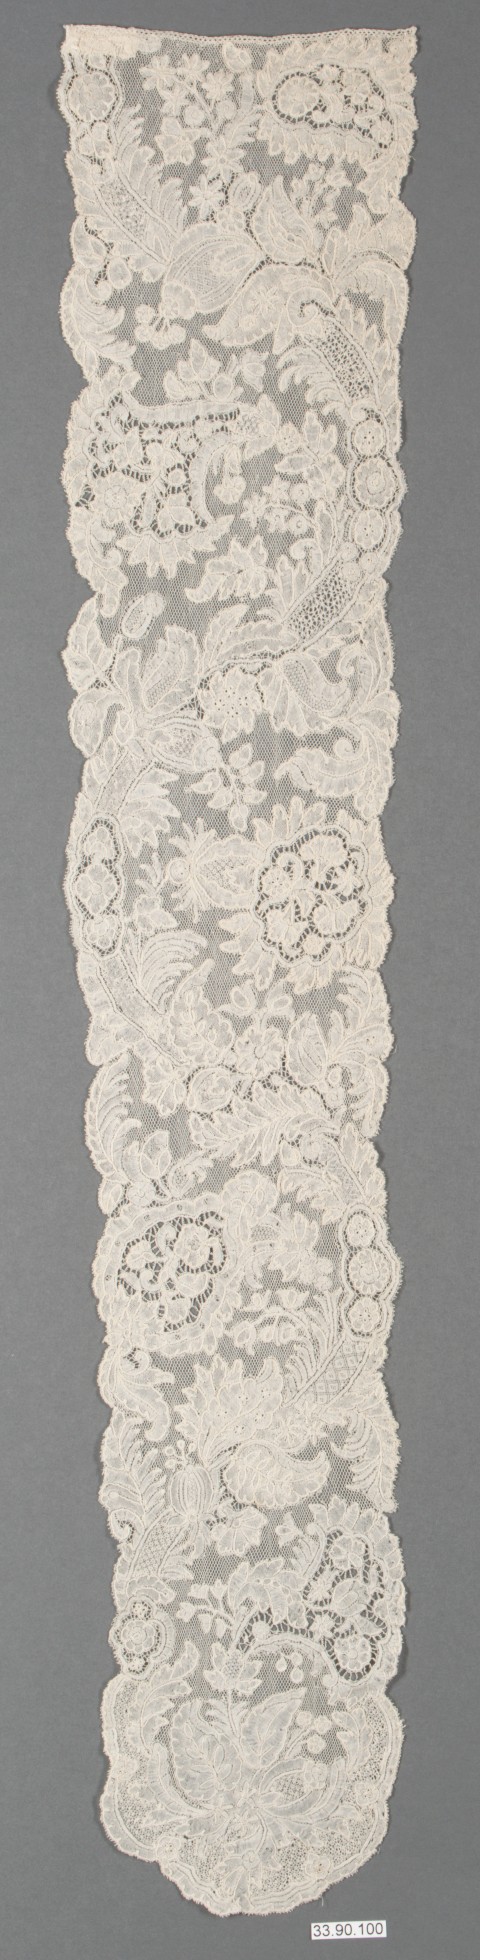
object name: lappet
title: Lappet (one of a pair)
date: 1734-1766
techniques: lace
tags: flowers